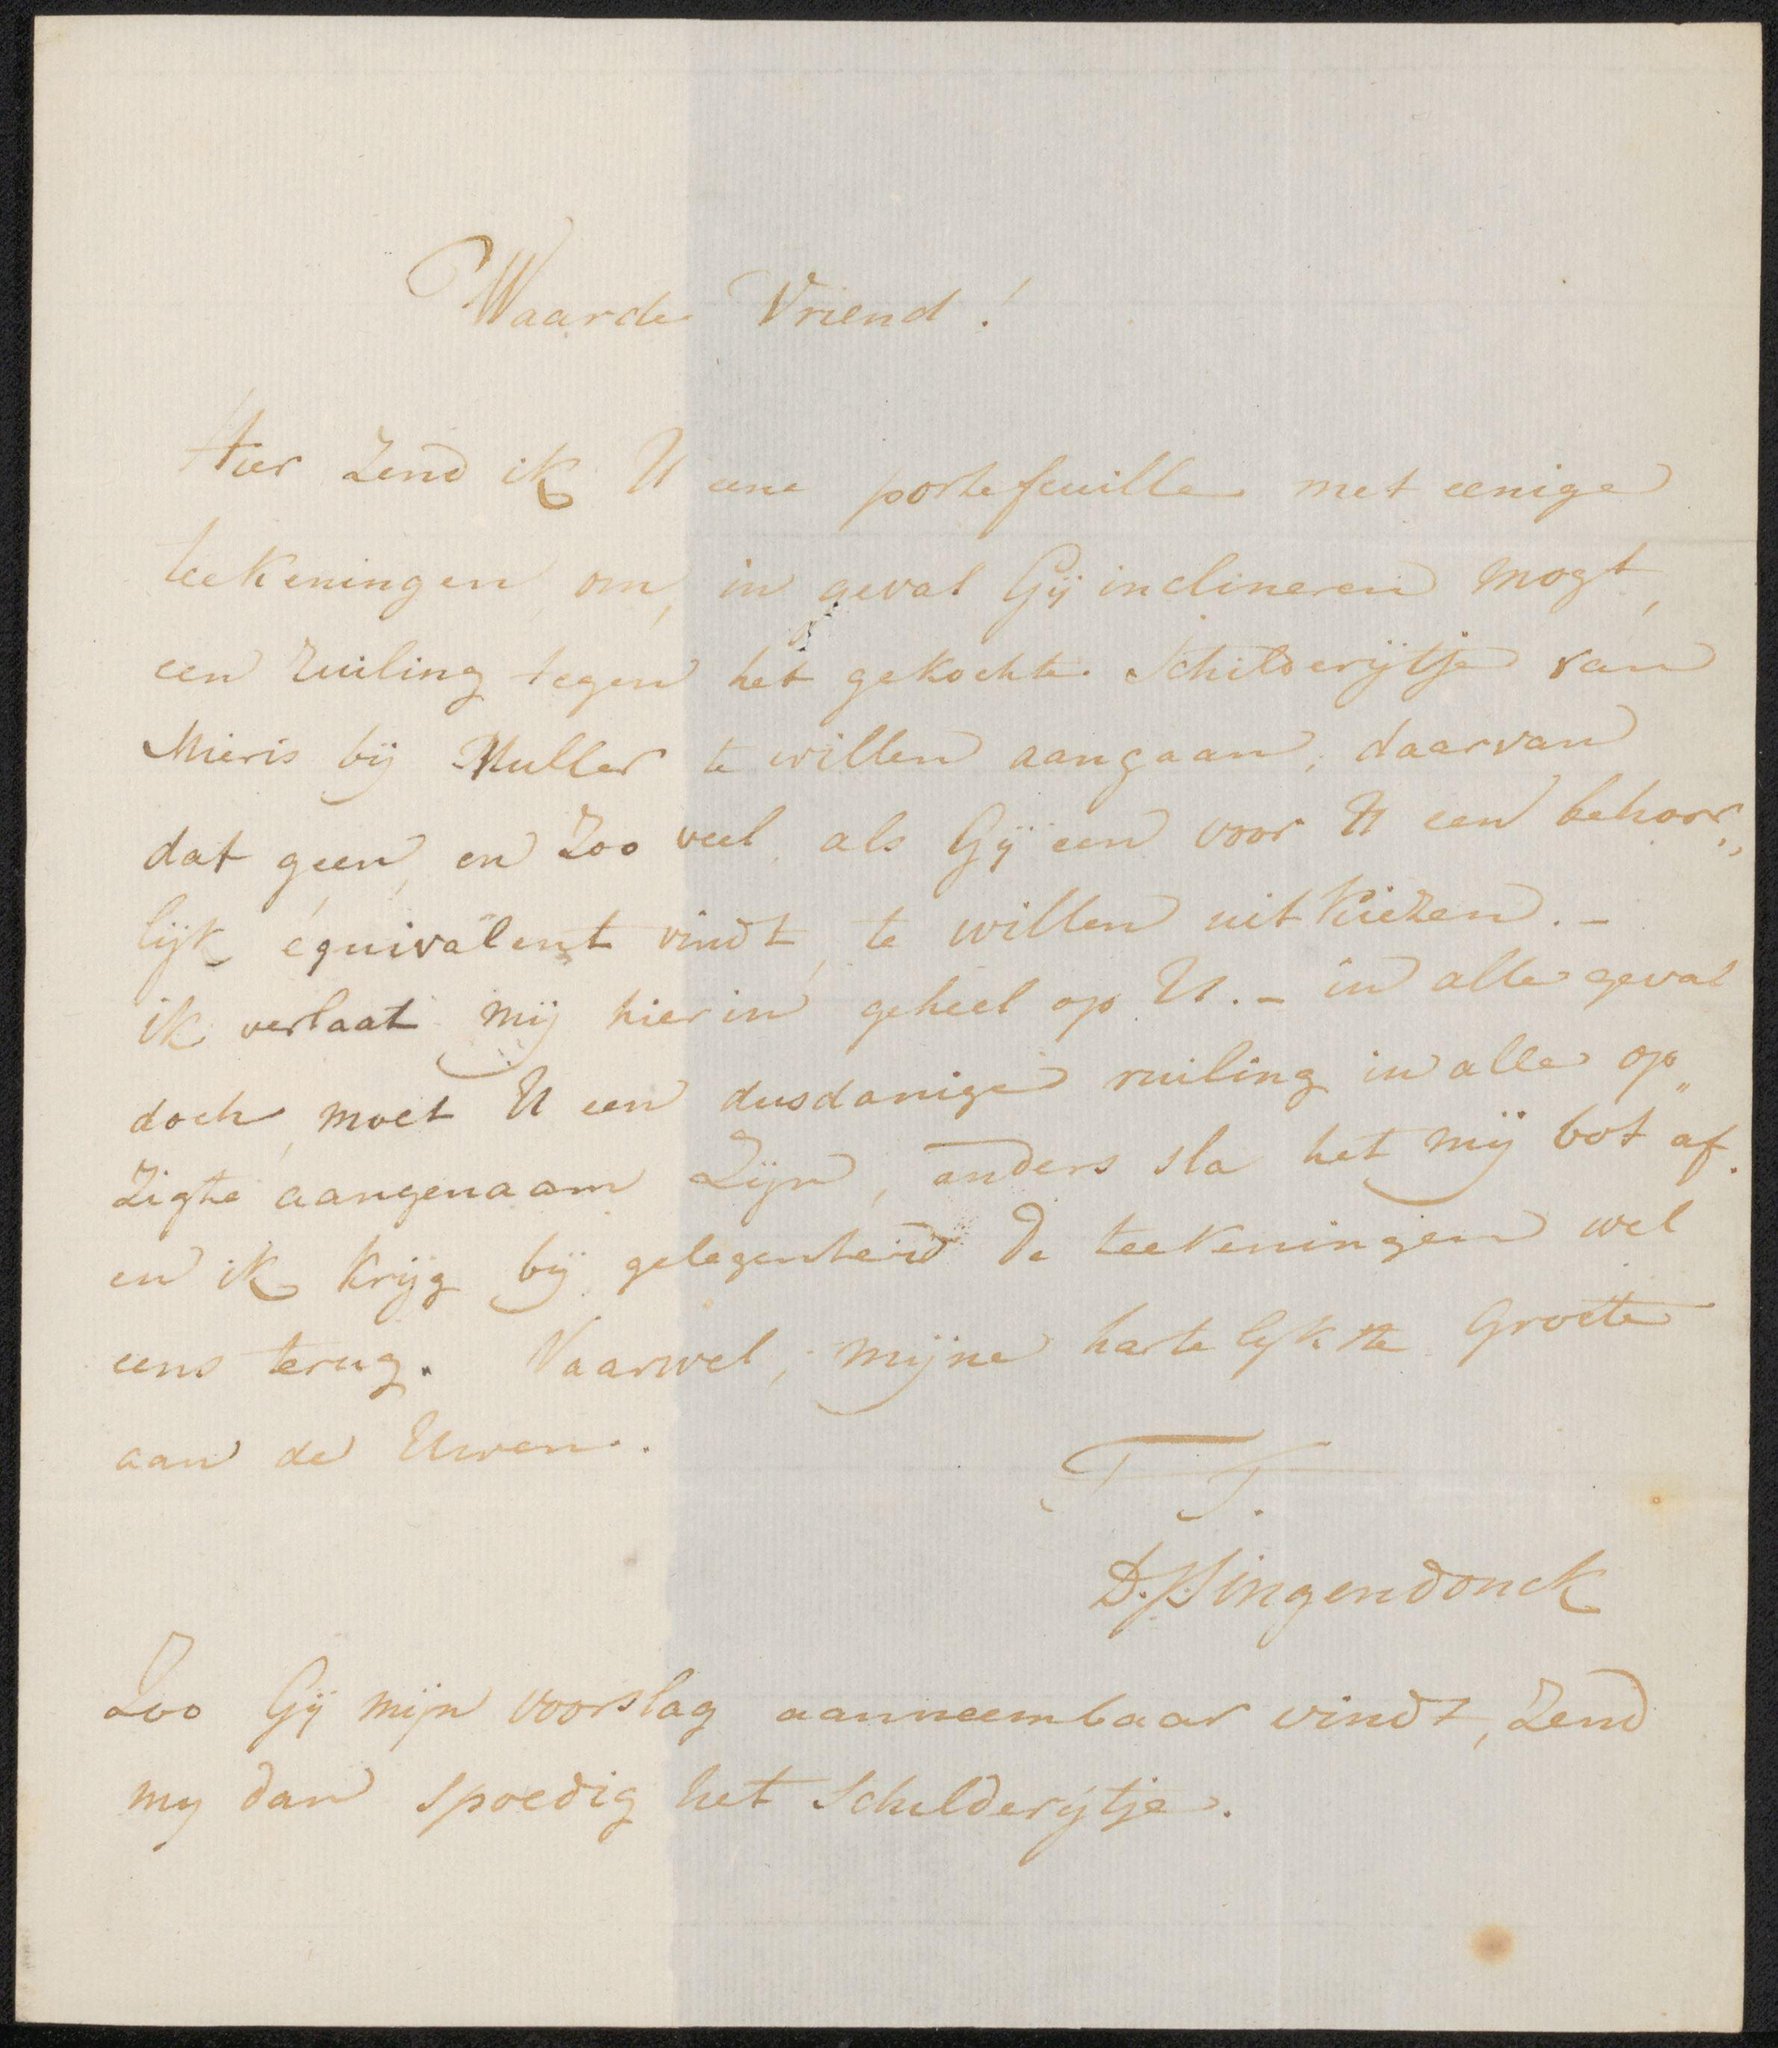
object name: letter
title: Brief aan anoniem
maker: diederik jan singendonck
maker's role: print maker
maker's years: 1784-1833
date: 1794-1833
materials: ink, paper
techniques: pen, writing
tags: drawing, painting (including book-illumination, miniature-painting)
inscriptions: seal, watermark